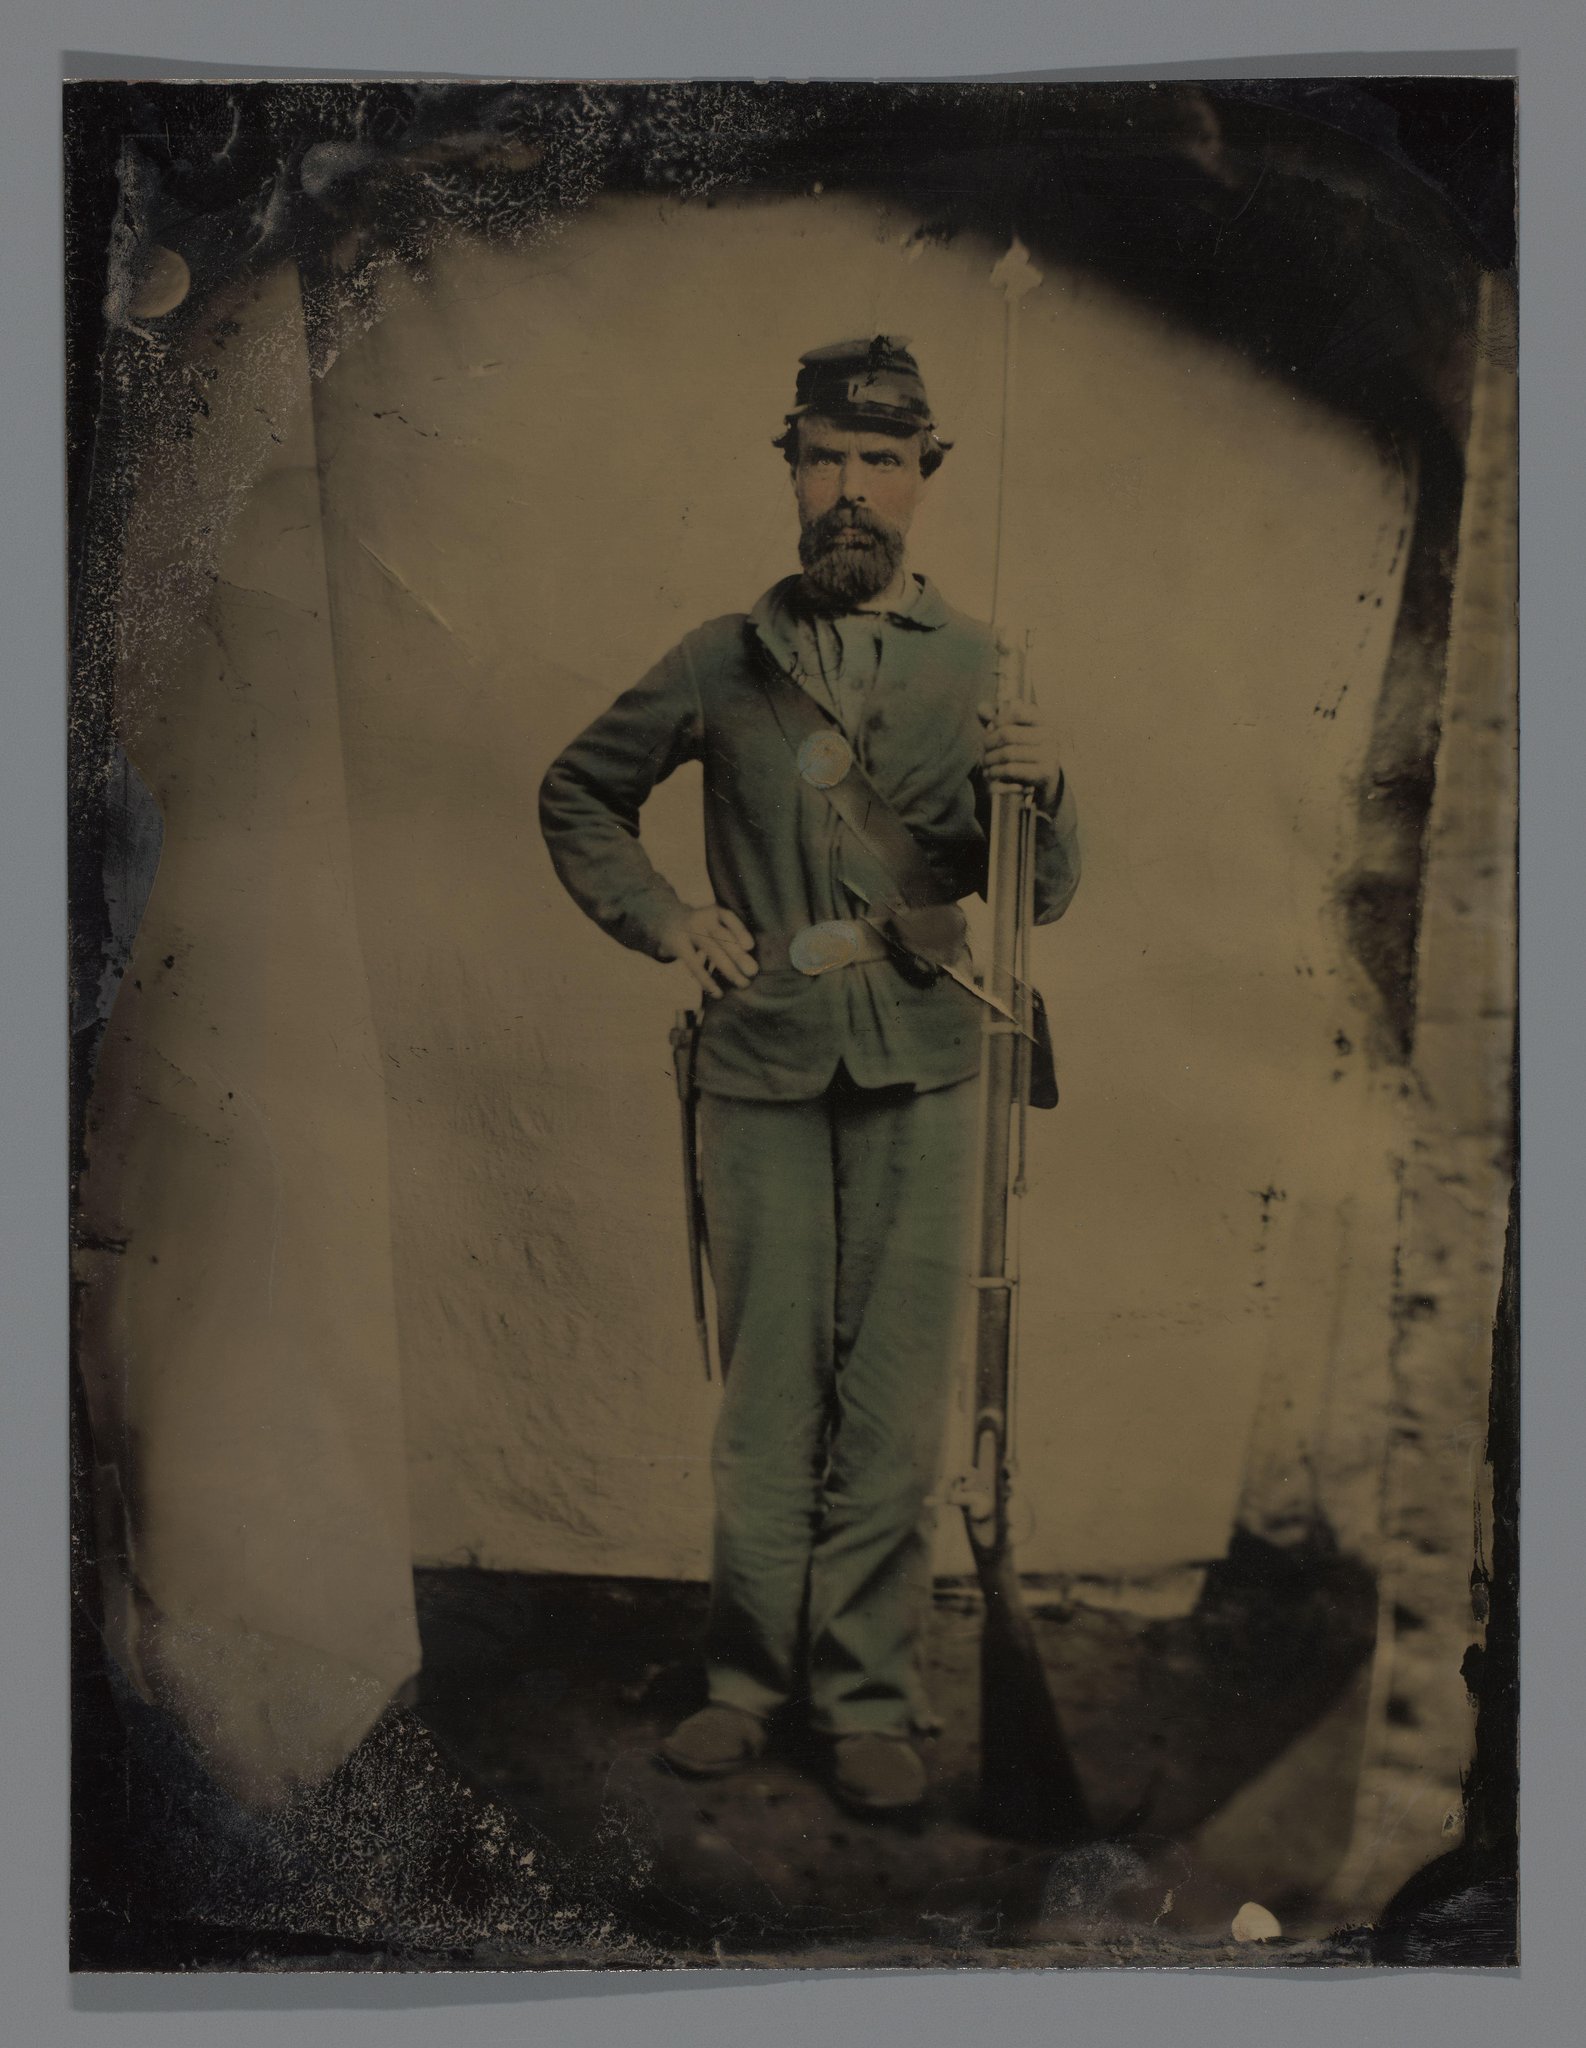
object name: photograph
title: Portret van een soldaat tijdens de Amerikaanse Burgeroorlog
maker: Anonymous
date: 1865-1867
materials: metal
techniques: ferrotyping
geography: united states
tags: united states of america